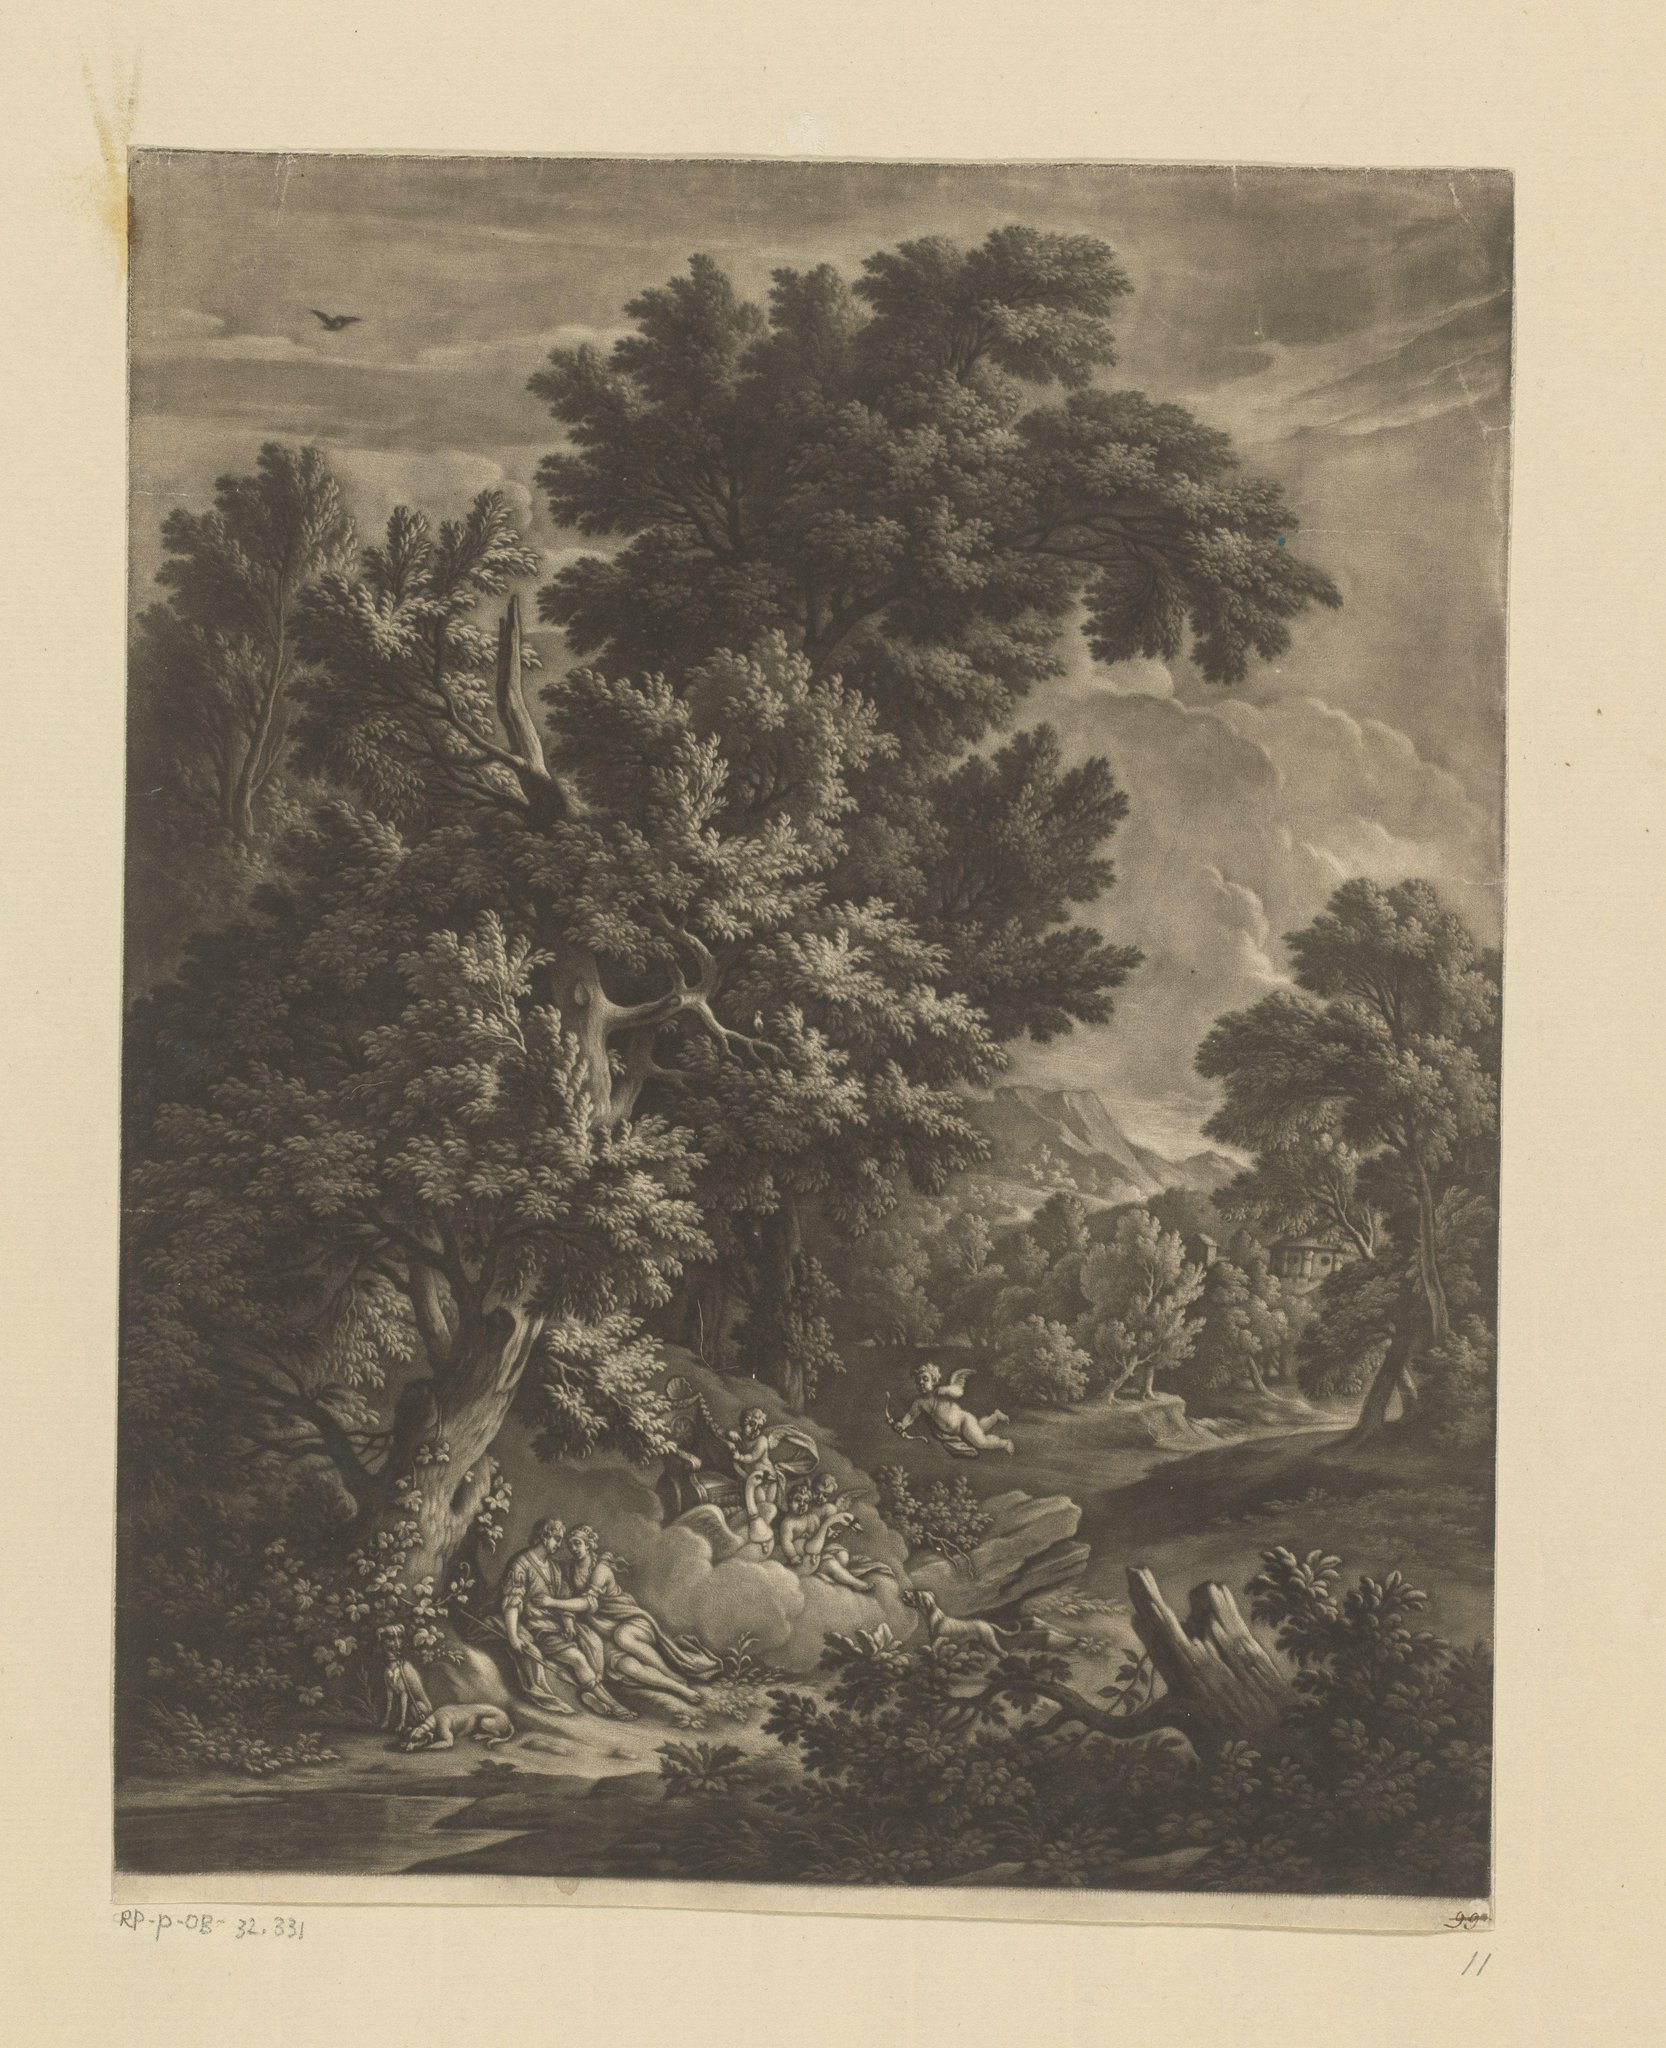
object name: print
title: Venus en Adonis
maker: bernard lens (ii)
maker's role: print maker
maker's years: 1659-1725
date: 1669-1725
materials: paper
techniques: mezzotint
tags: venus and adonis as lovers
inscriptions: collector's mark: Lugt 240